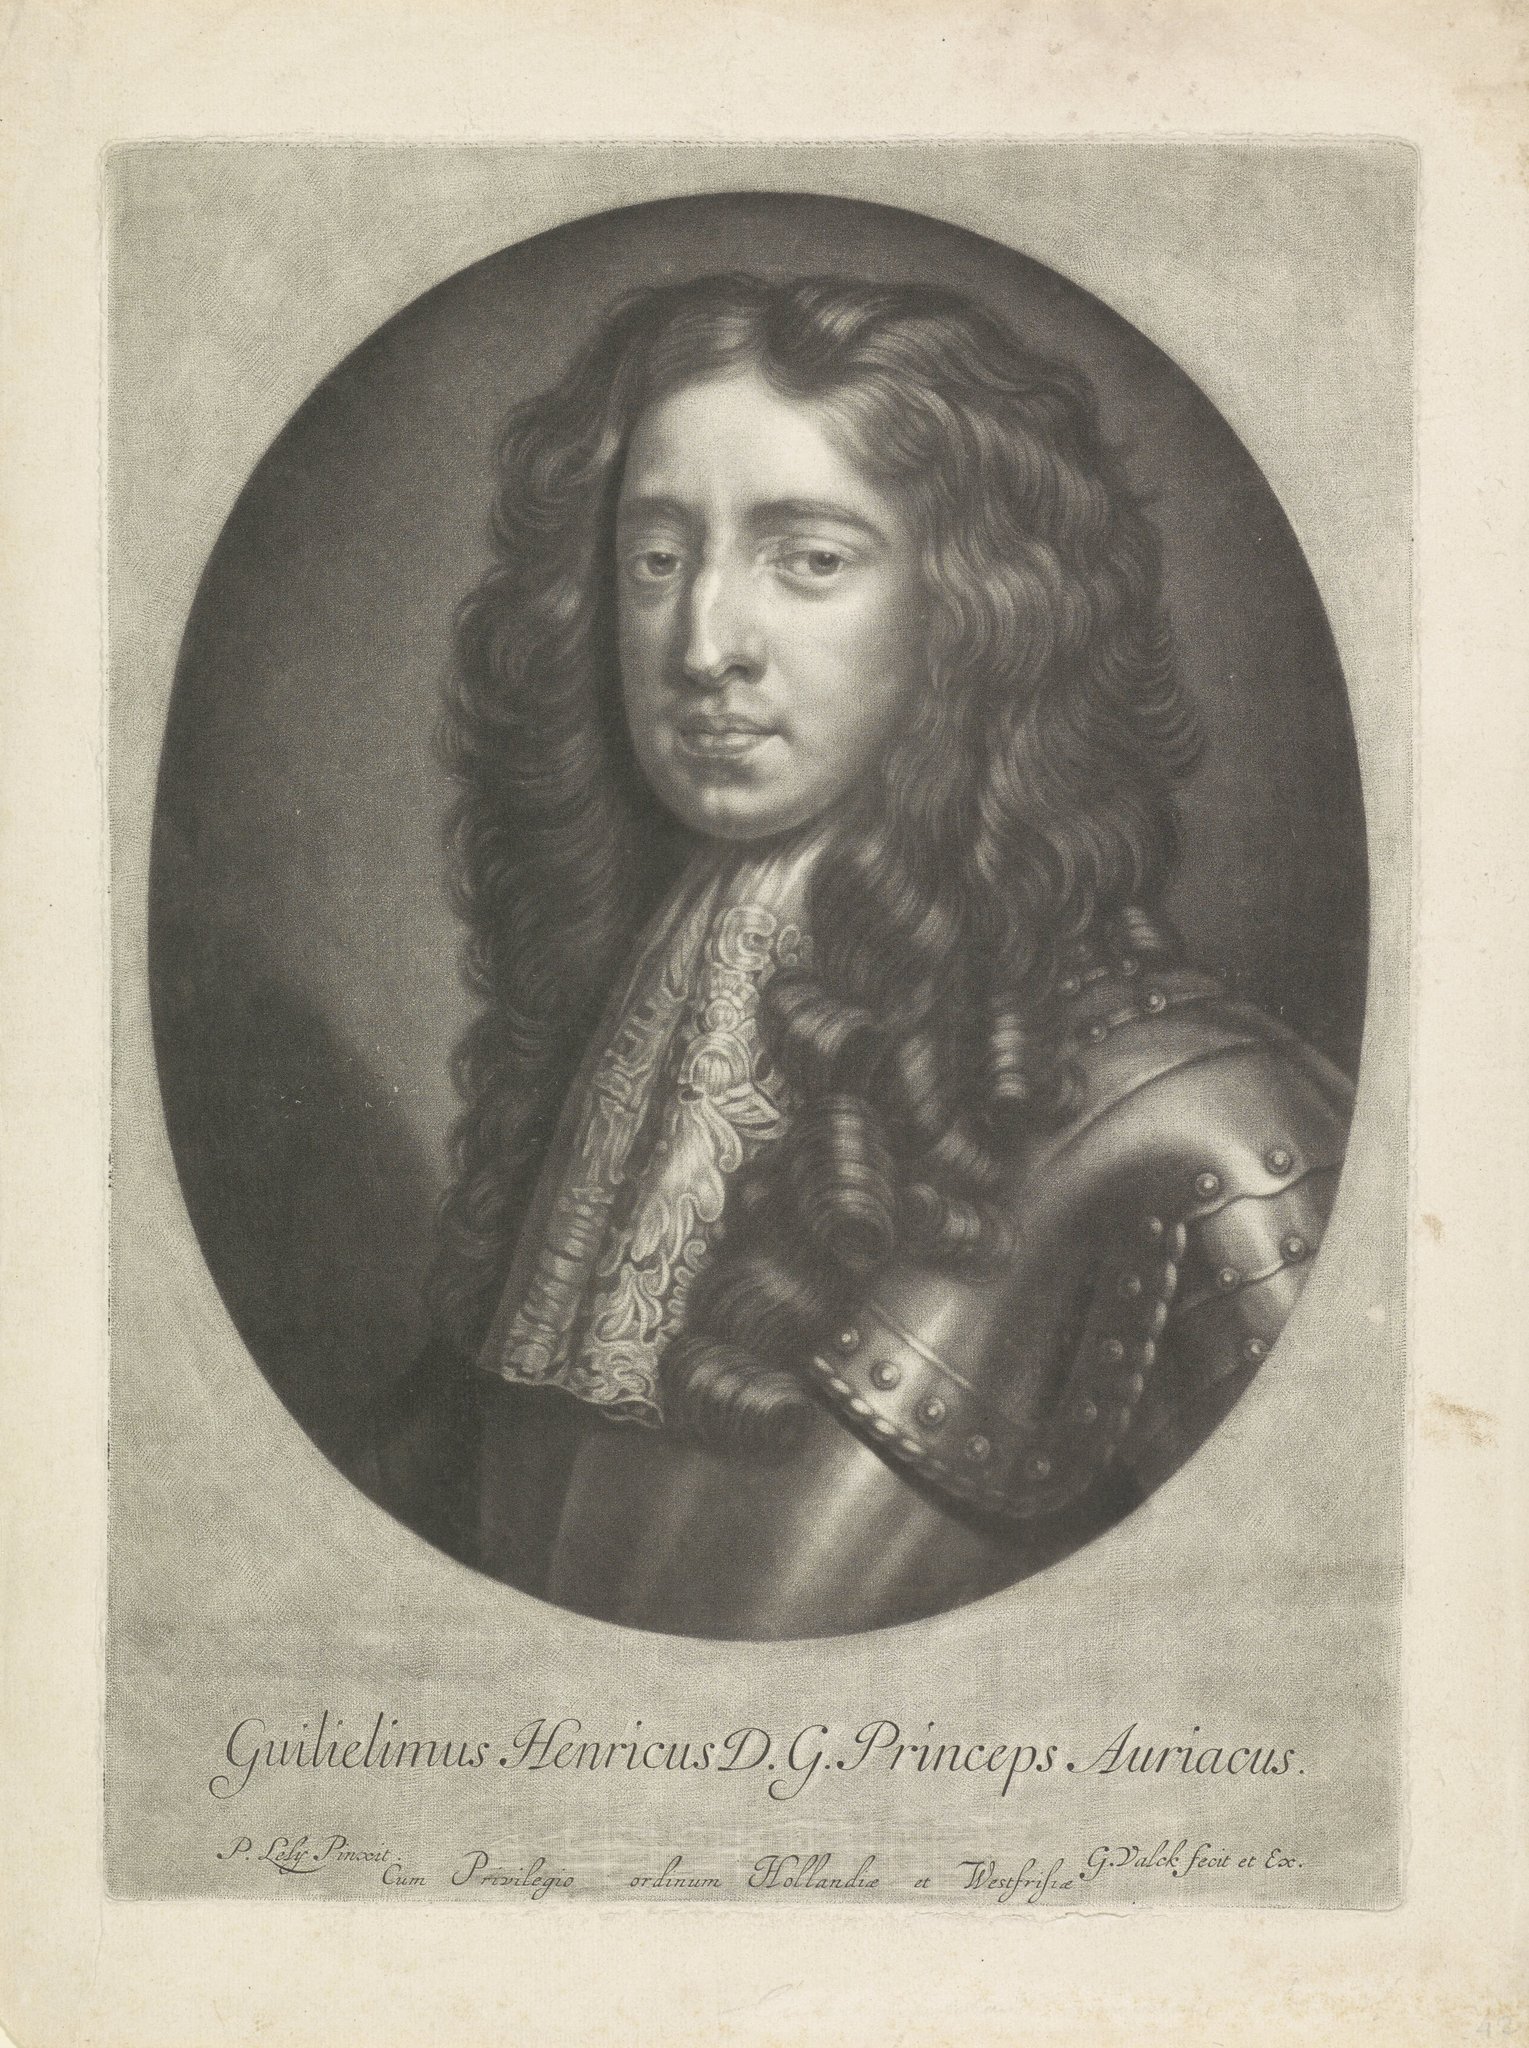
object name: print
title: Portret van Willem III, prins van Oranje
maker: peter lely (sir)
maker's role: draughtsman, painter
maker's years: 1618-1680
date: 1670-1726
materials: paper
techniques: mezzotint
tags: the hague, william iii (prince of orange and king of england, scotland, and ireland)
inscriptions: collector's mark: Lugt 2228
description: De hier vermelde titel verwijst naar de hoogst verkregen titel van de geportretteerde, niet per se naar de titel die de geportretteerde op deze voorstelling draagt.